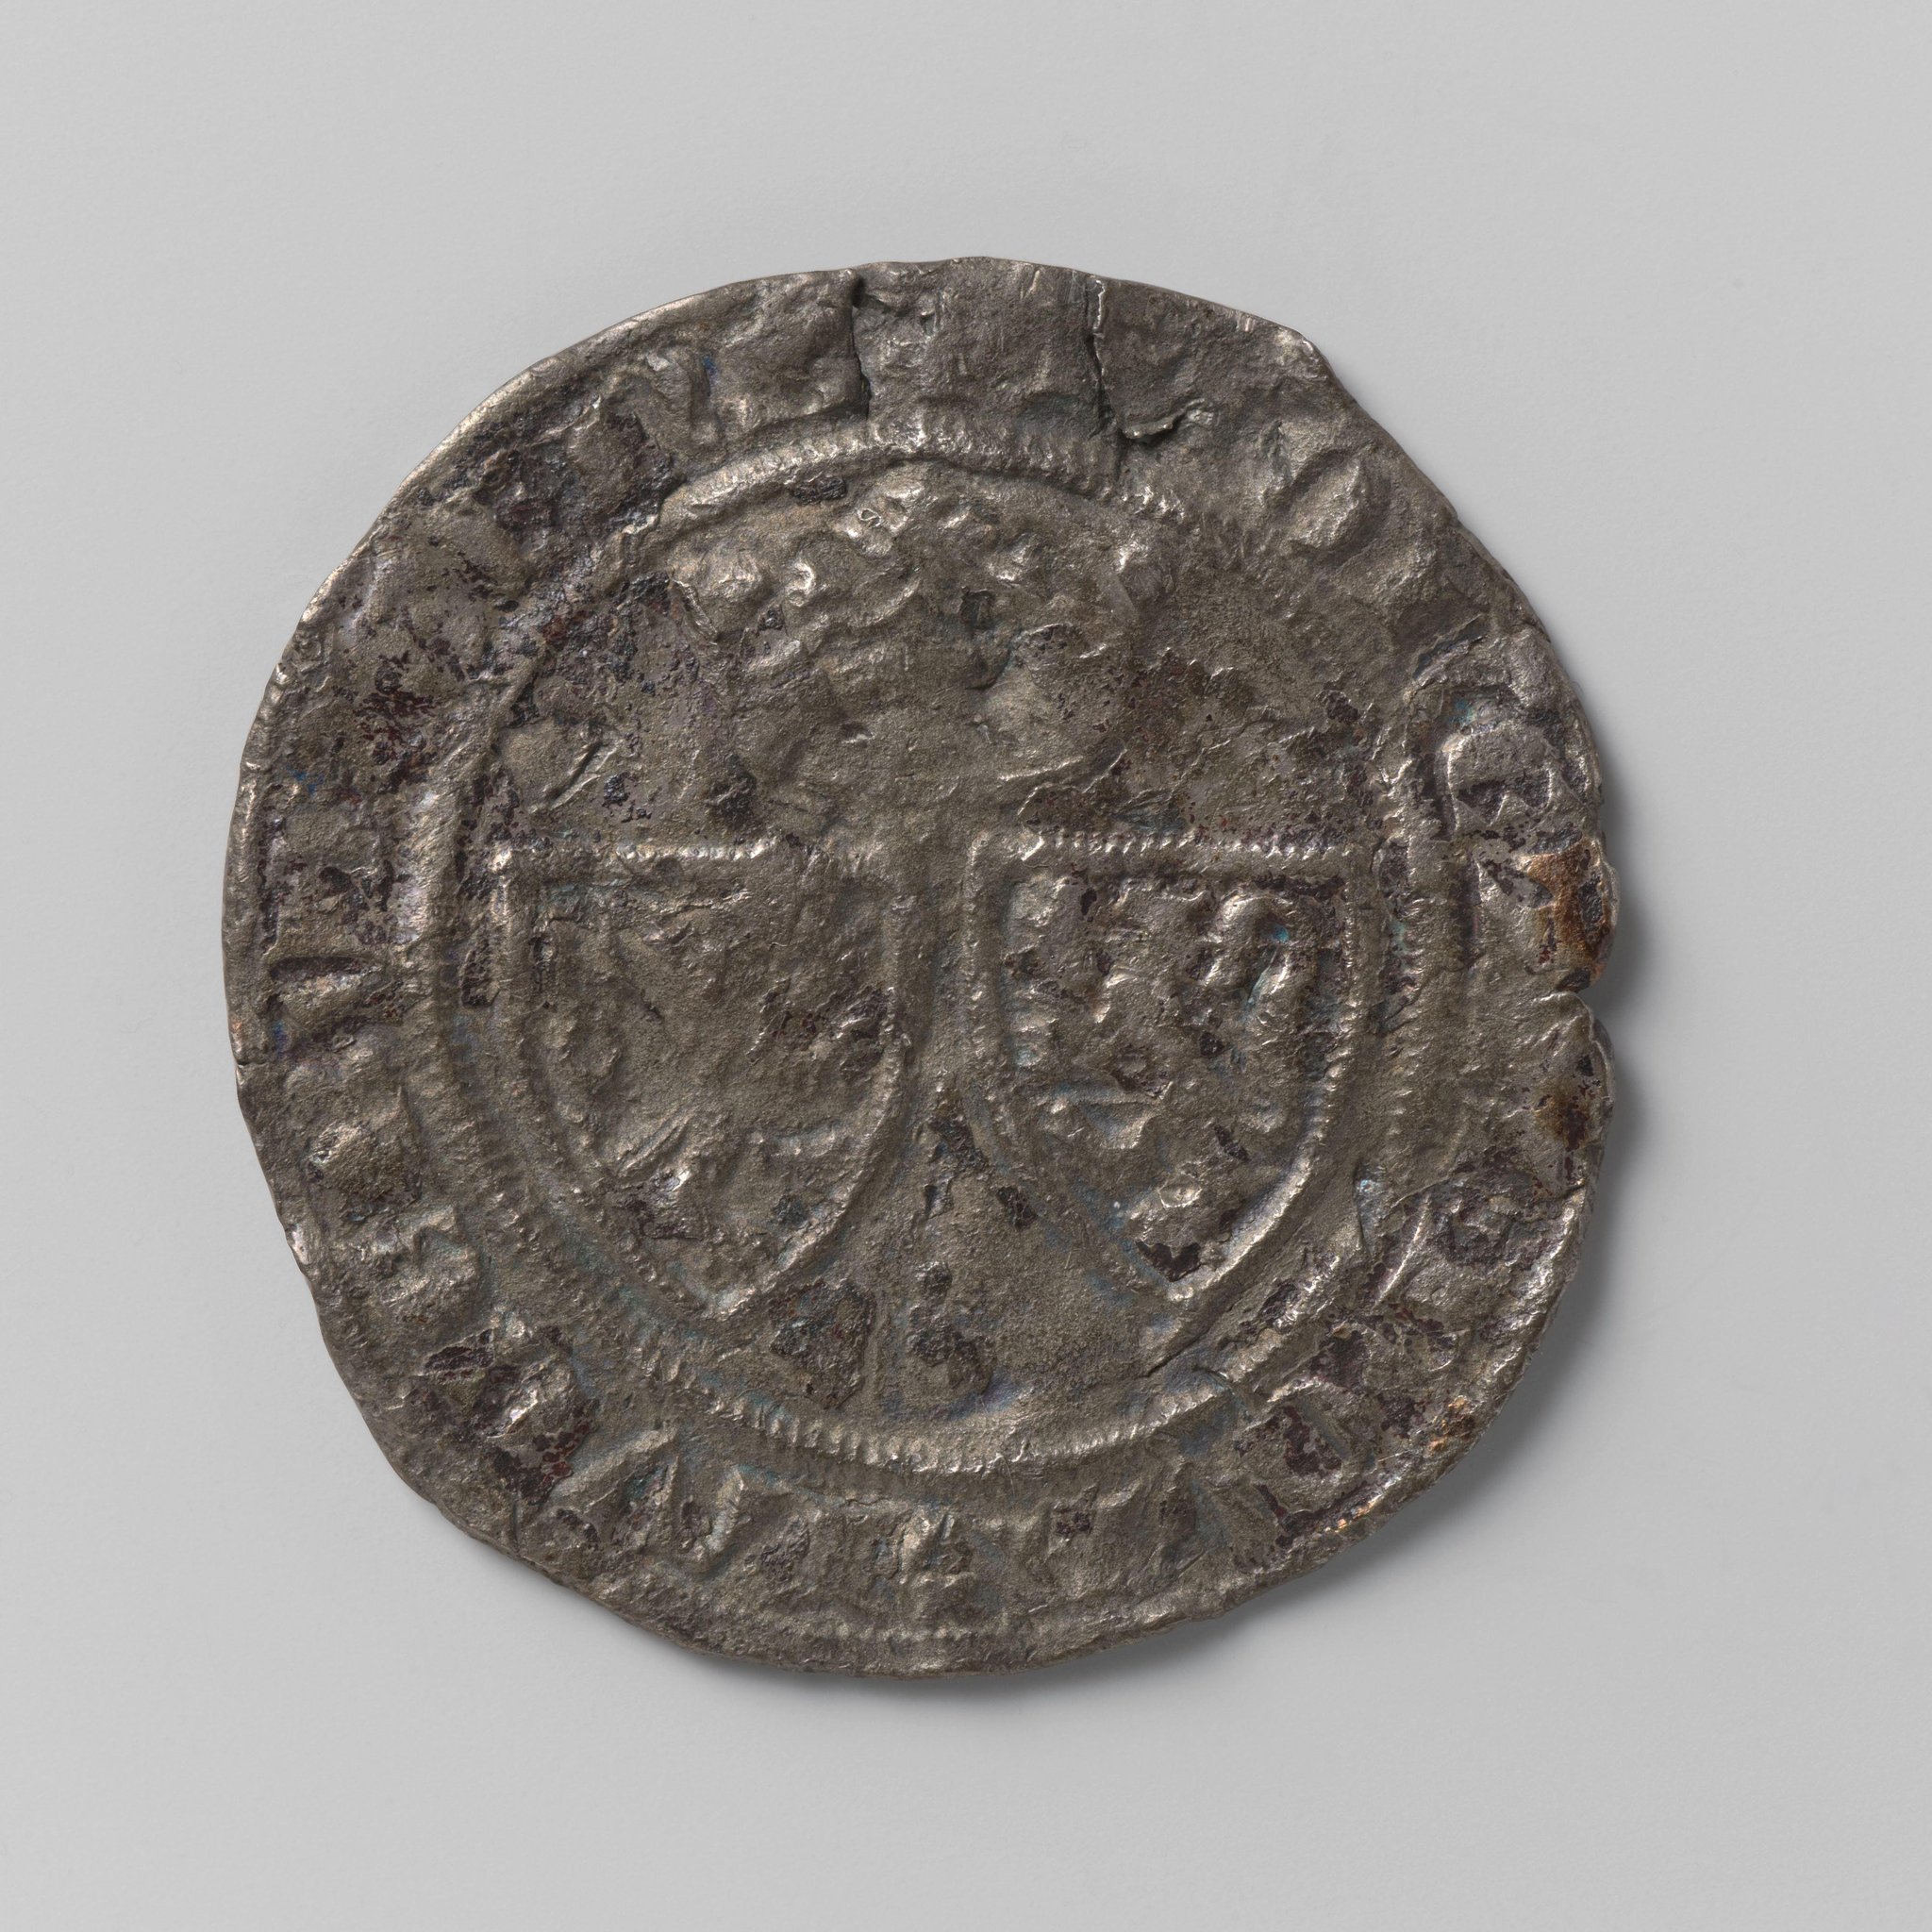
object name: coin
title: Luxemburgse groot met de twee schilden van Wenceslaus II, 1383-1388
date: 1383-1388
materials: silver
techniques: striking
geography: luxembourg city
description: Zilveren munt. Voorzijde: kort versierd kruis, in het hart vier kruisjes . Keerzijde: onder een kroon twee naast elkaar geplaatste, naar elkaar toegewende wapenschilden, van Bohemen [omgekeerd] en van Luxemburg.